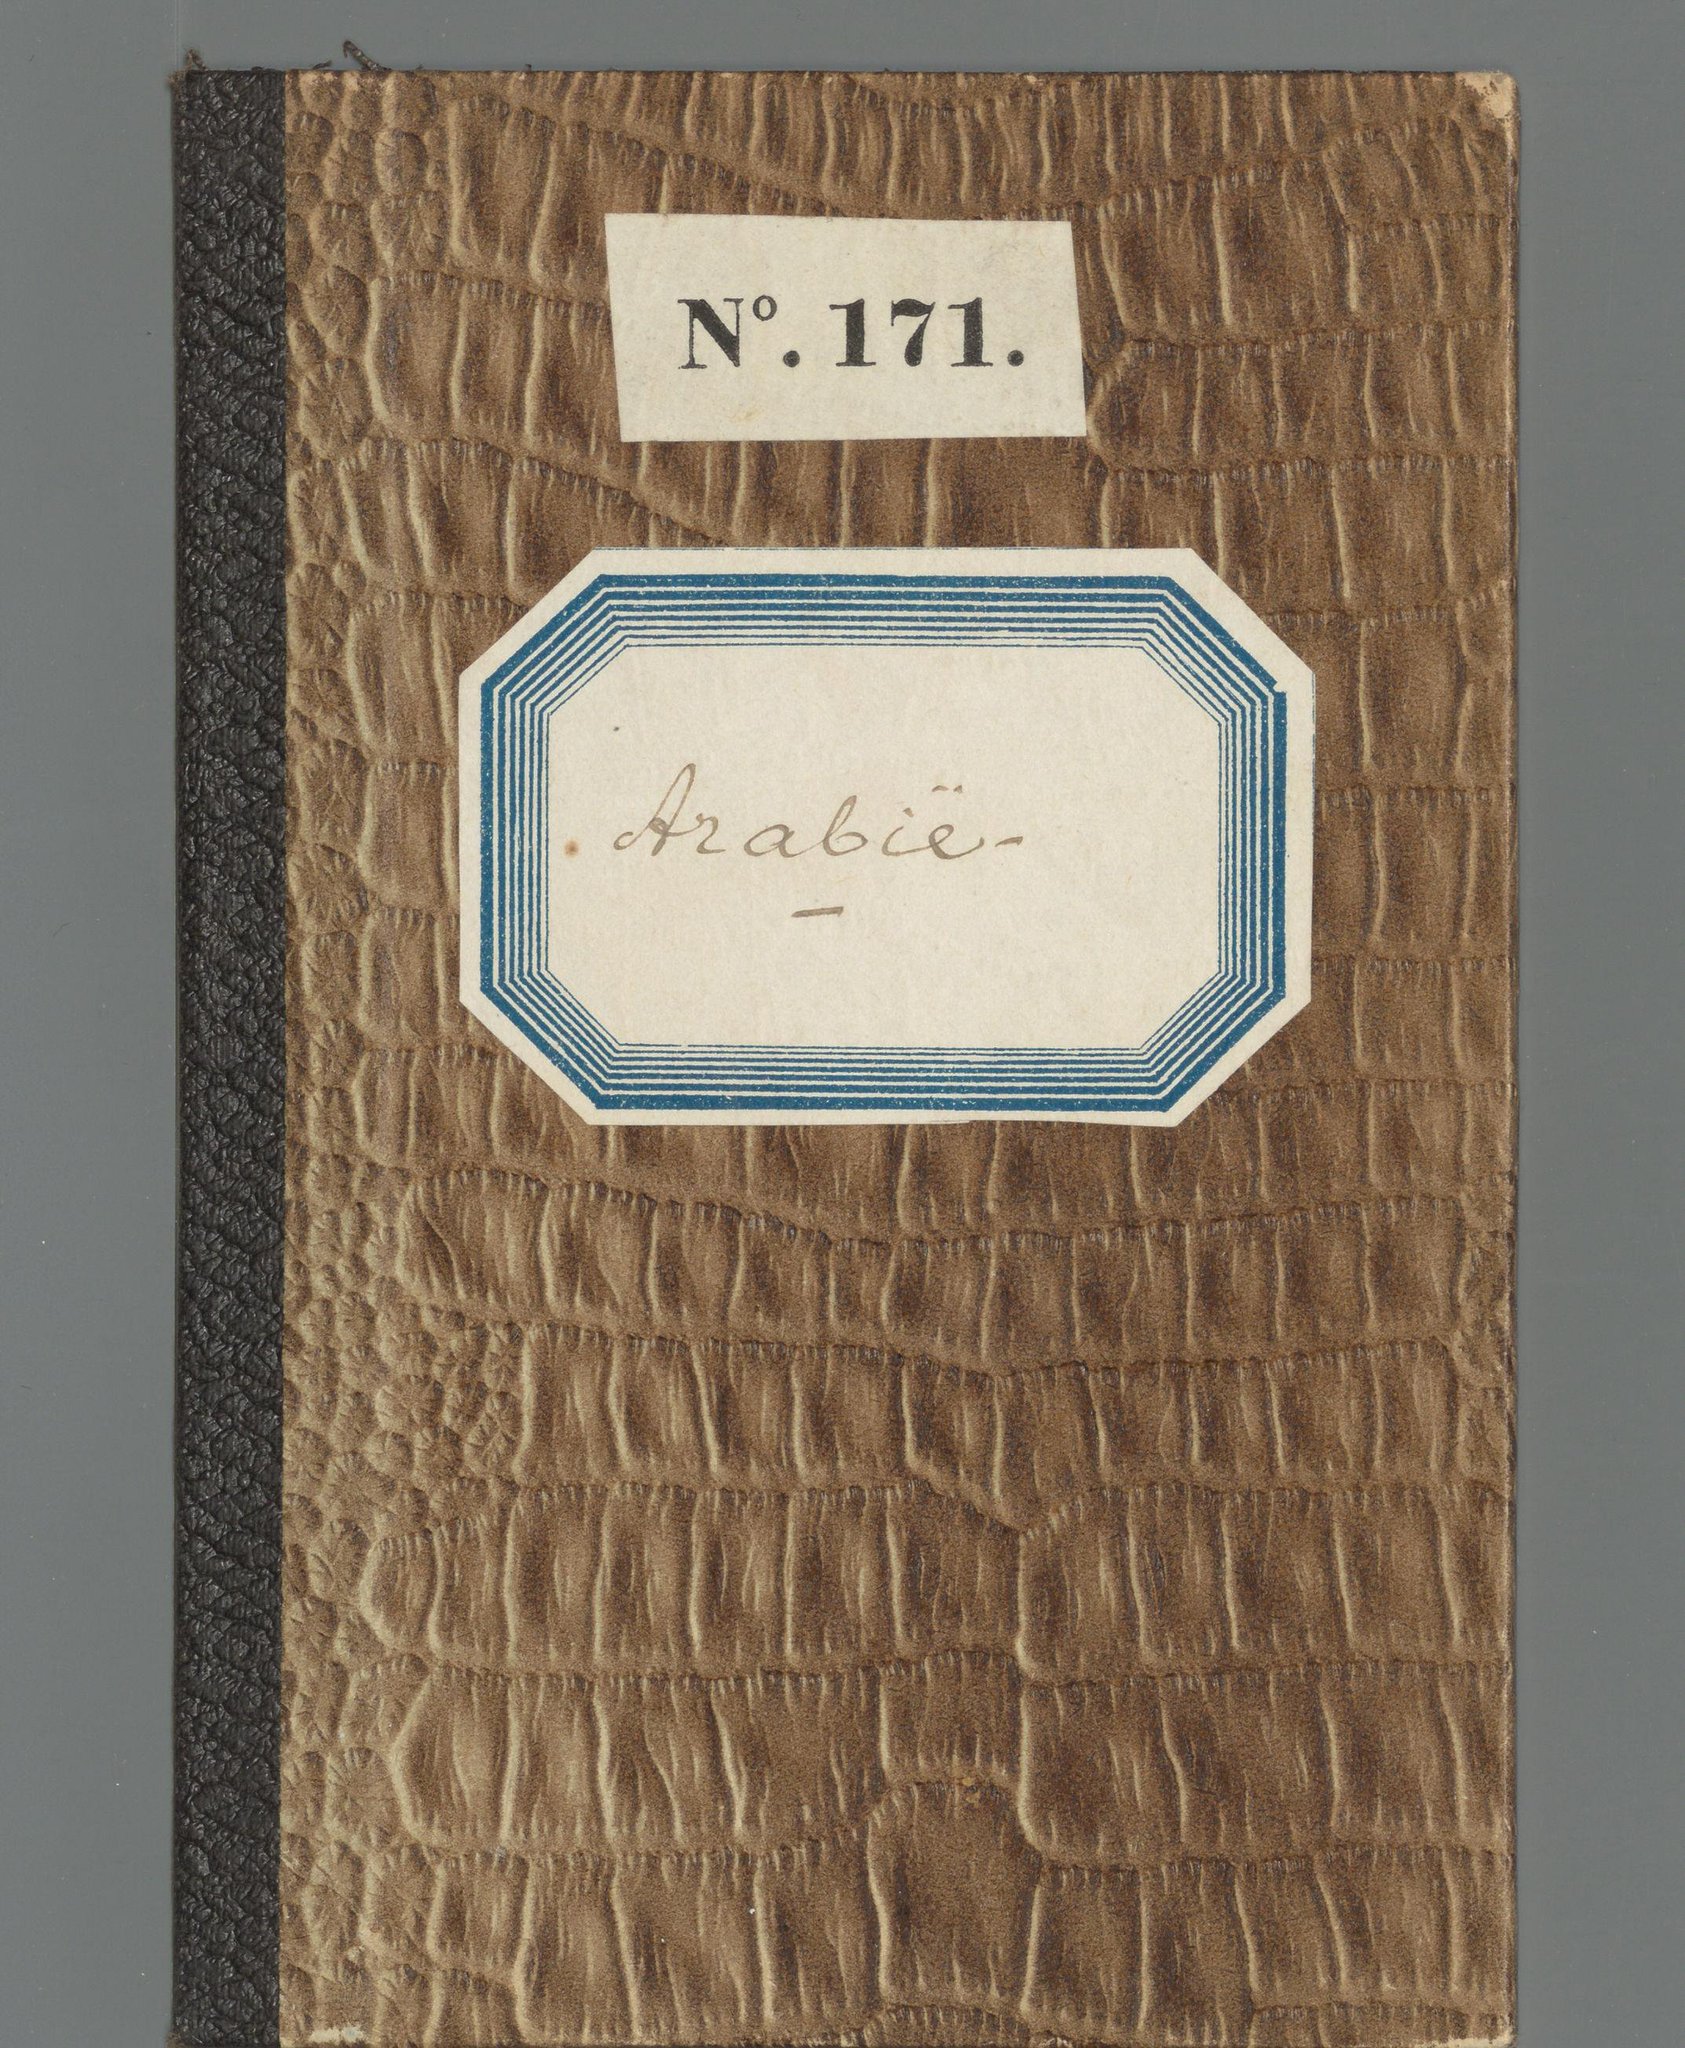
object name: wrapper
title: Omslag voor 21 prentbriefkaarten met gezichten uit Tunesië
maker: Anonymous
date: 1900-1950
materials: cardboard, paper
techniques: lithograph, writing